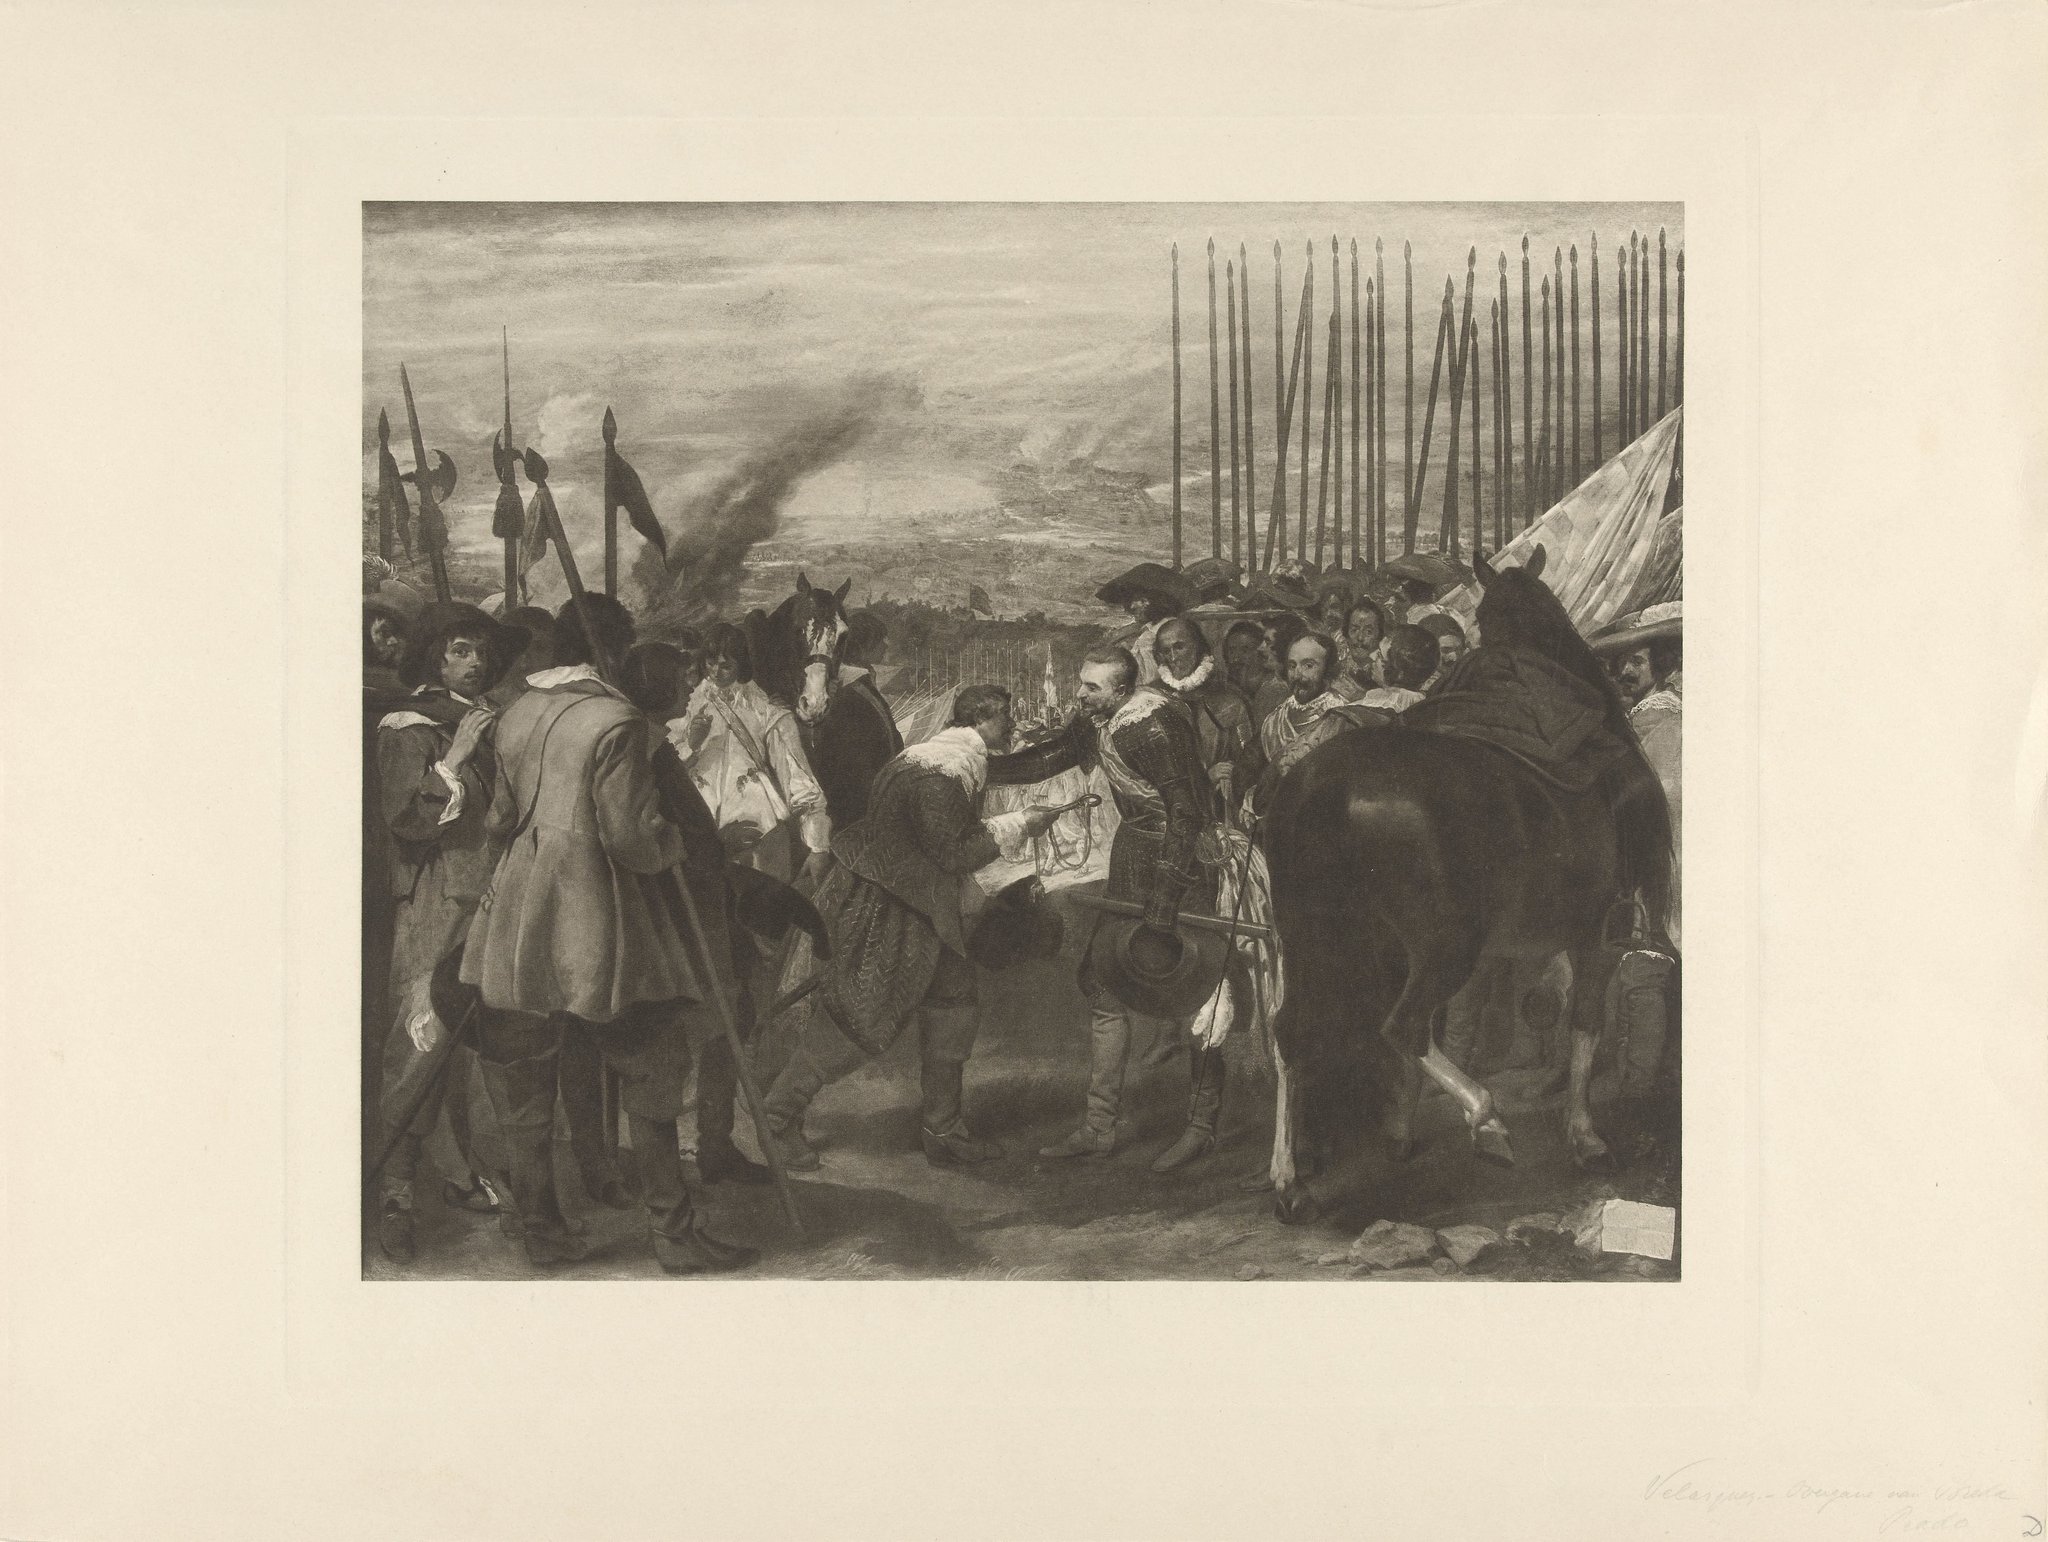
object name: print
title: De hoefsmid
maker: johannes arnoldus boland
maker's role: print maker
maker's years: 1838-1922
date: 1866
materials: paper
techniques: etching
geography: amsterdam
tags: farrier, shoeing-smith, herding, herdsman, herdswoman, shepherd, shepherdess, cowherd, etc.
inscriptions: collector's mark: Lugt 2228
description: Illustratie voor J.P. van der Kellen, Le peintre graveur hollandais et flamand, Utrecht: 1866.